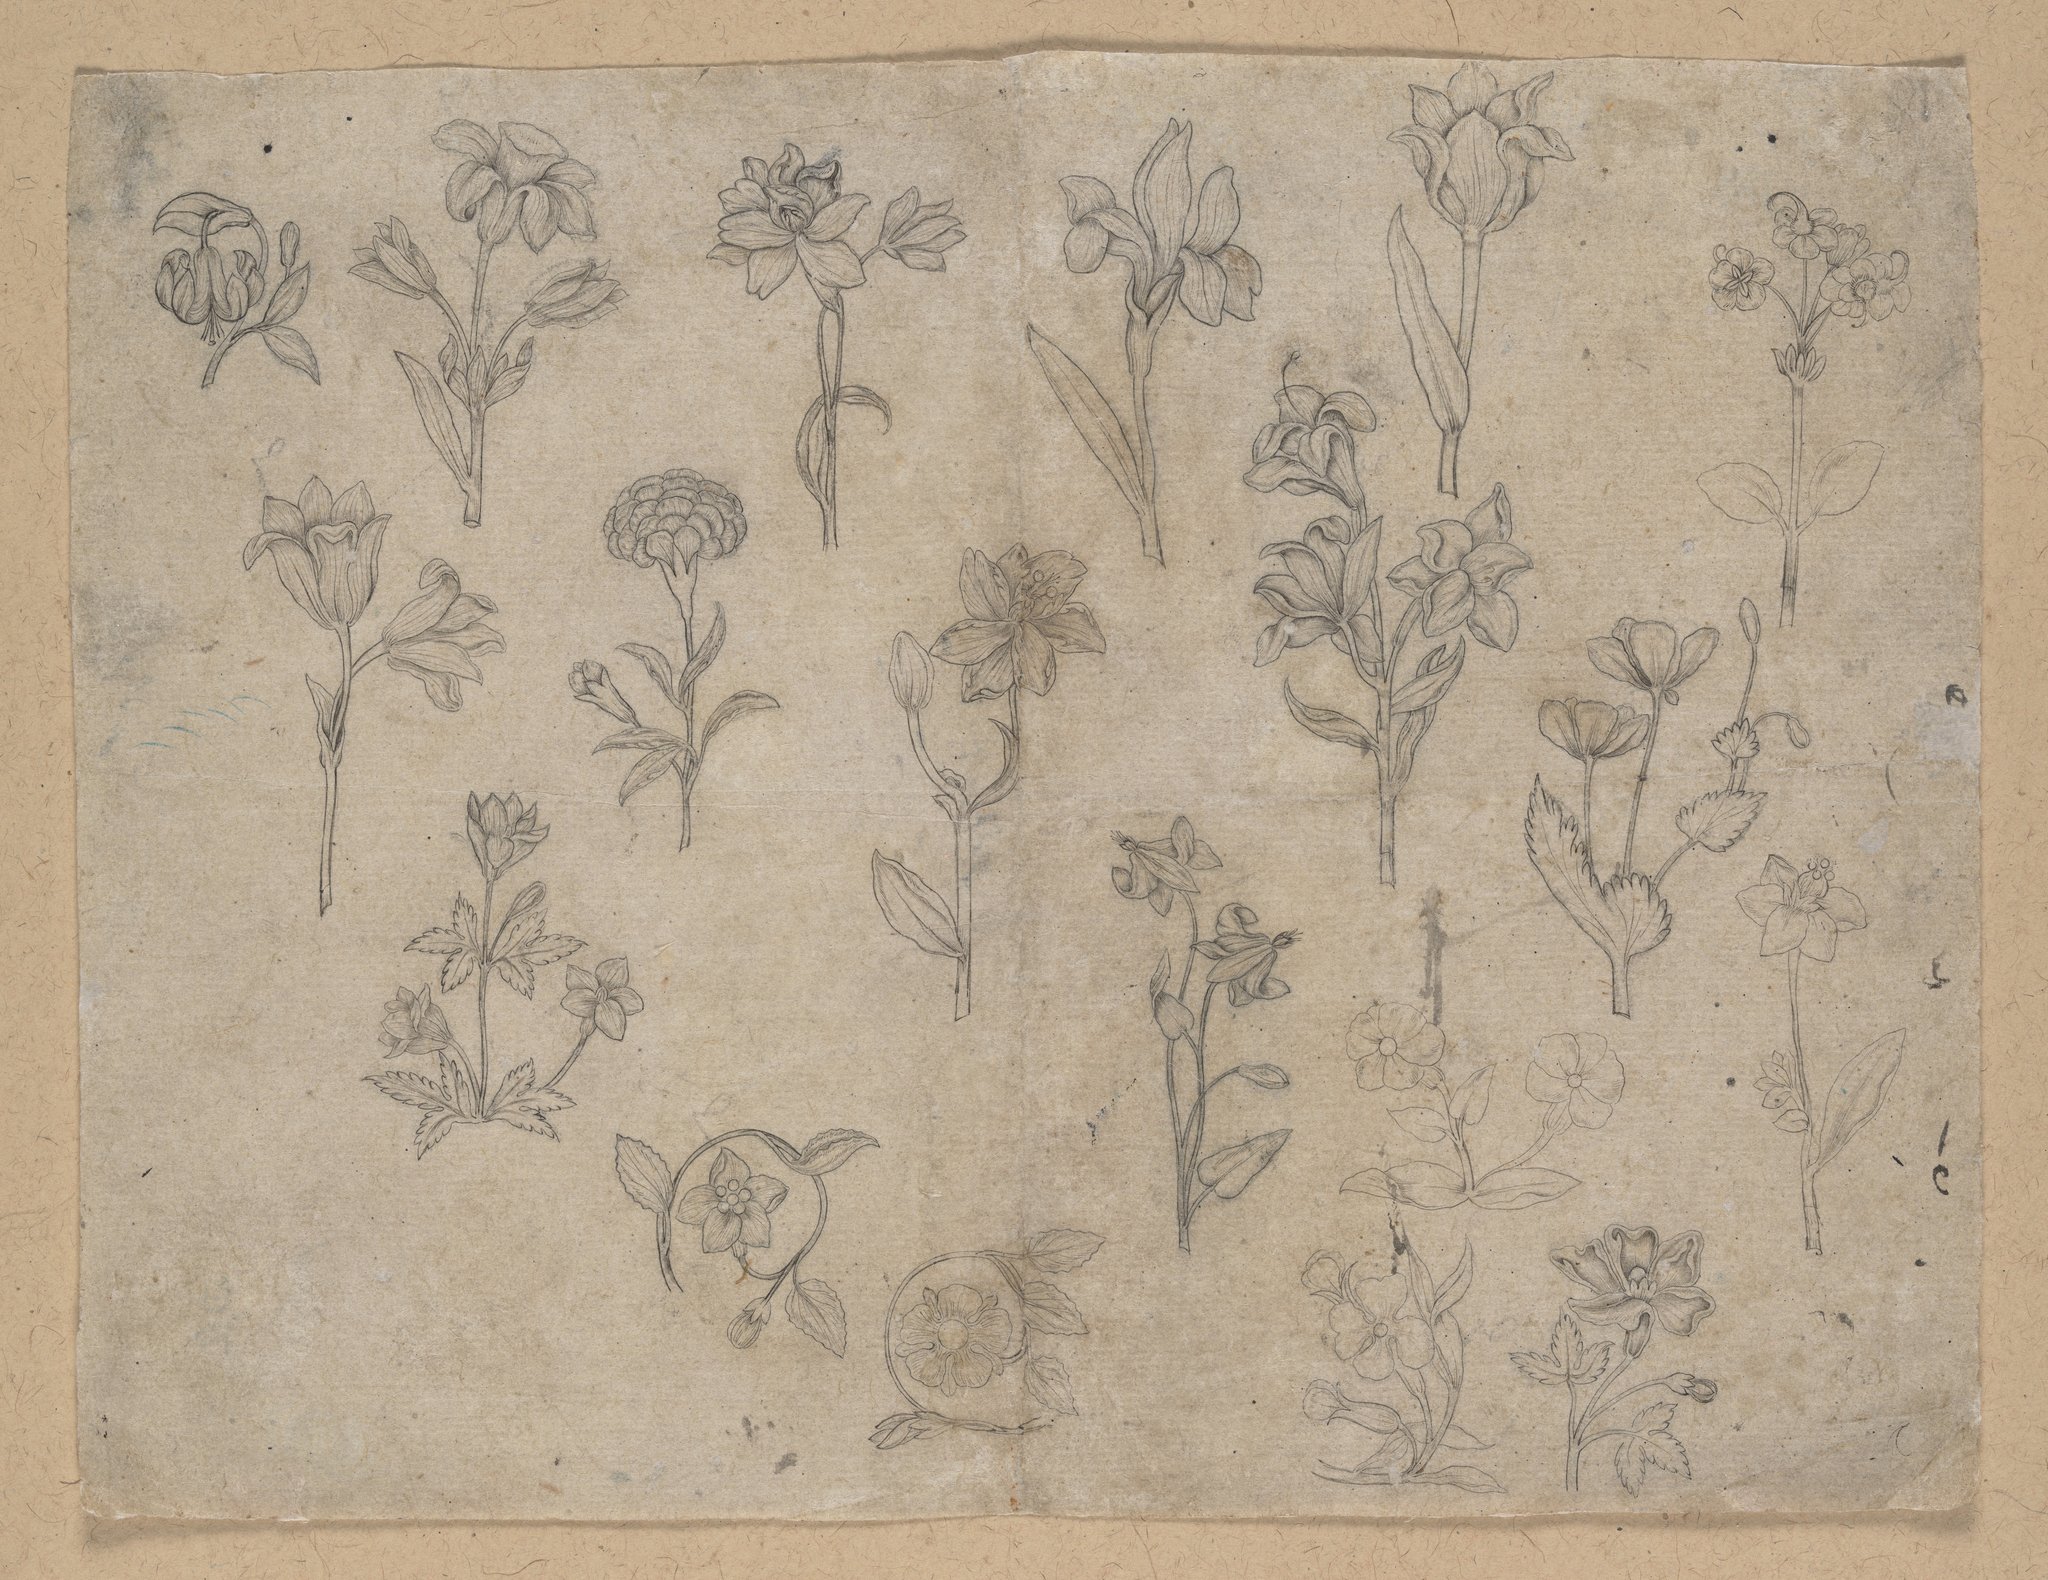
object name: illustrated single work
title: Flower Studies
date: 1650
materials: ink, paper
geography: india